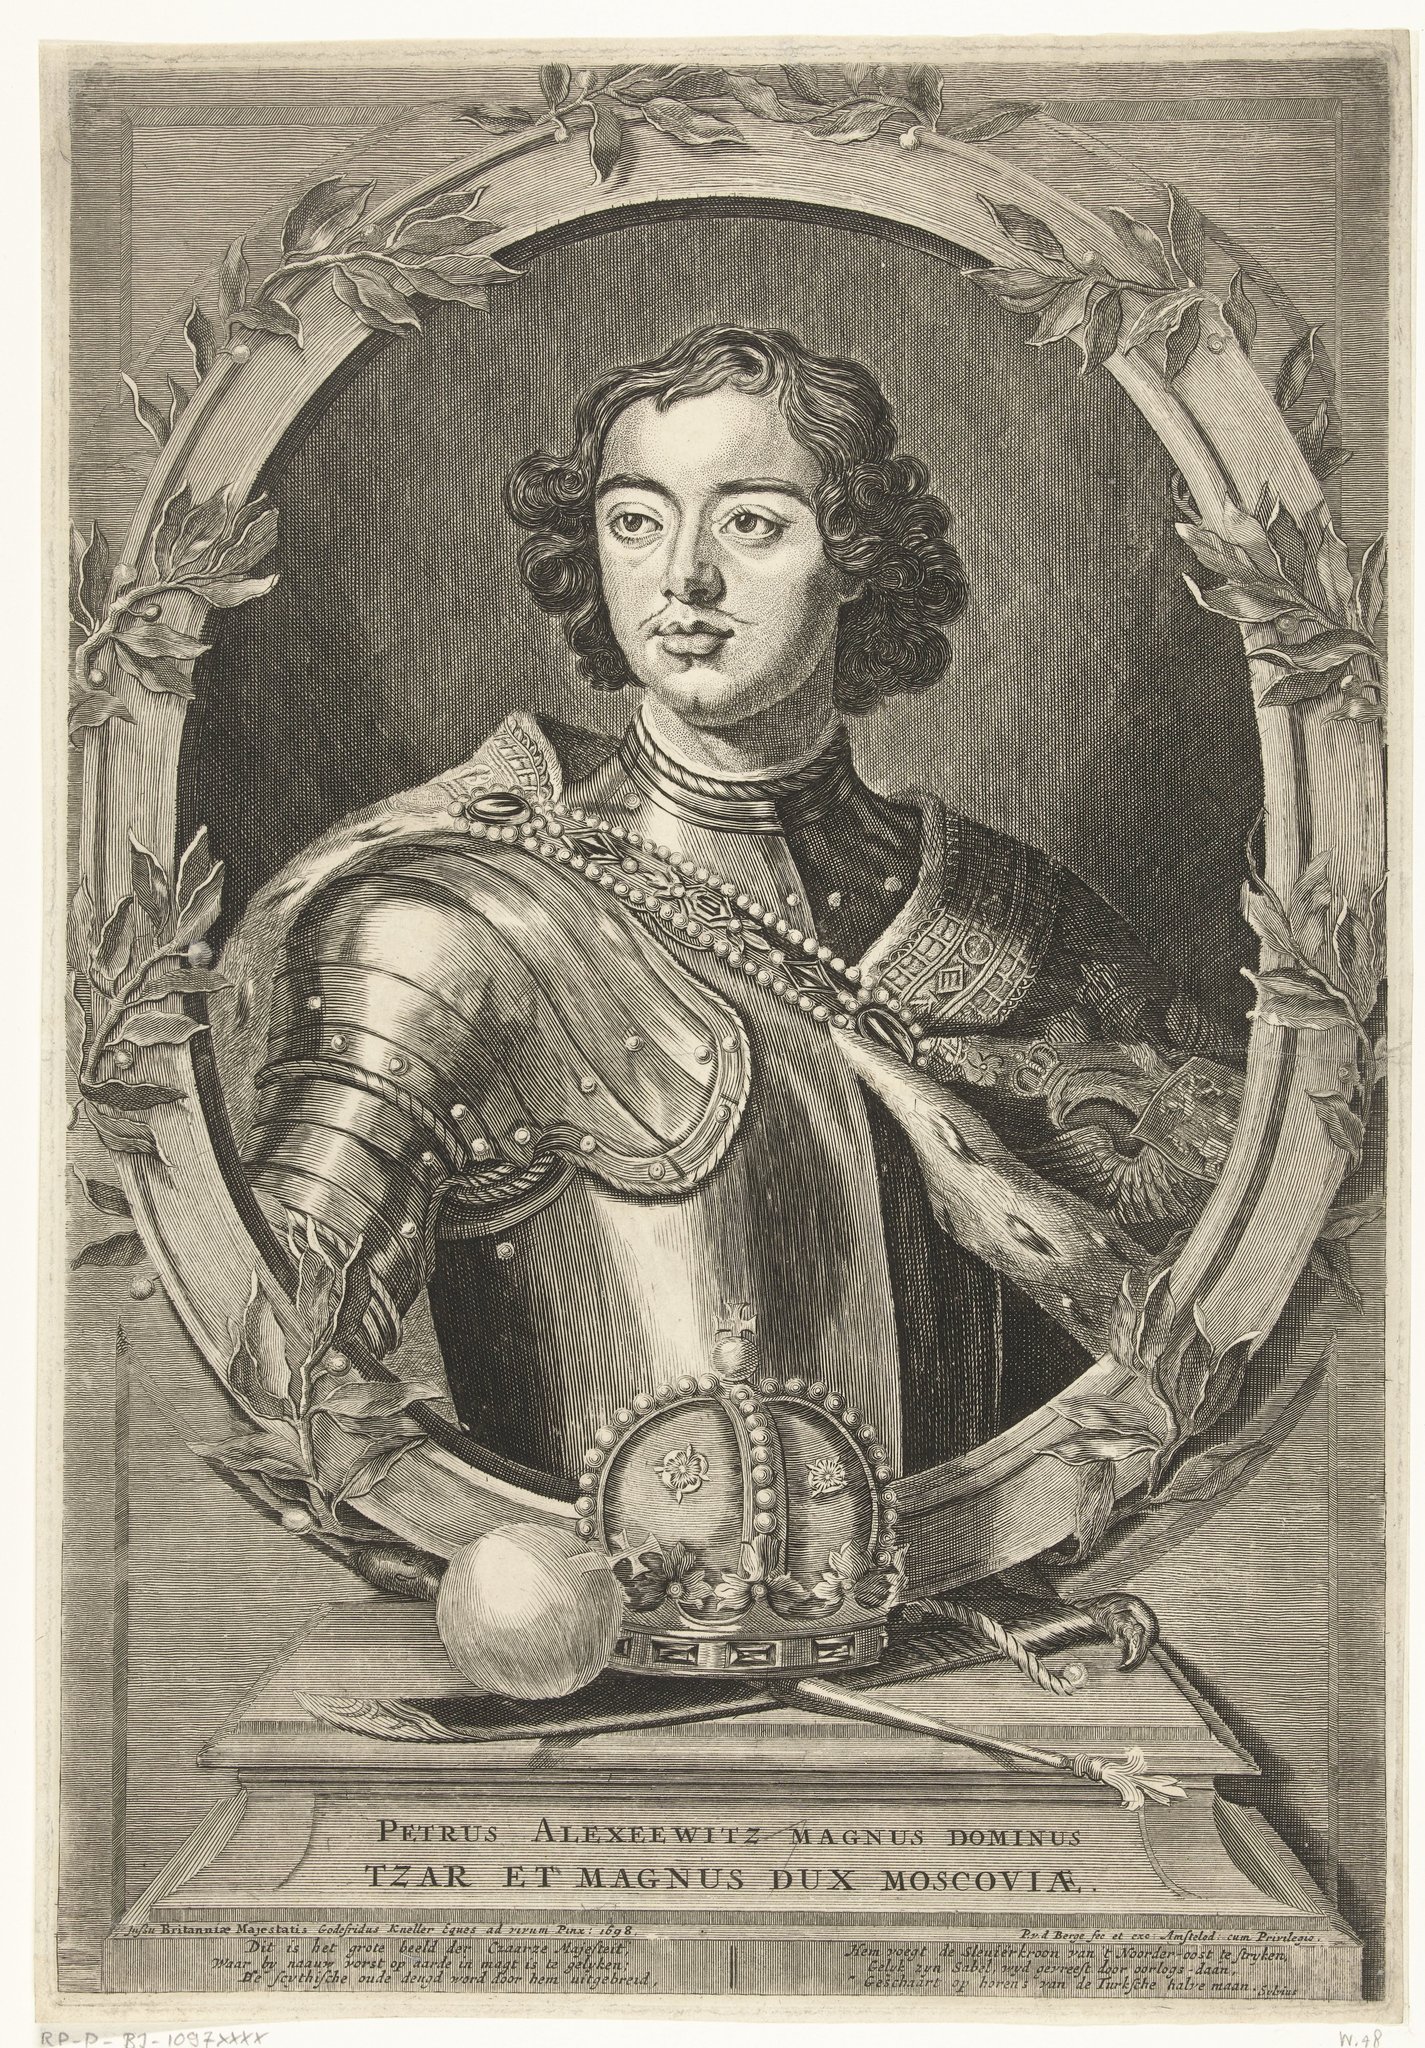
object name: print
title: Portret van Peter I de Grote, tsaar van Rusland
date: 1698-1737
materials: paper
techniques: engraving, etching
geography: amsterdam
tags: peter i de grote (tsaar van rusland), historical persons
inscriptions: collector's mark: Lugt 2228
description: Borstbeeld van Peter de Grote met harnas in een ovale lijst versierd met bladranken. Voor de lijst liggen op een stenen sokkel een kroon, scepter en een rijksappel. Onder de voorstelling een Nederlands vers door Samuel Sylvius op de heldendaden van de tsaar.